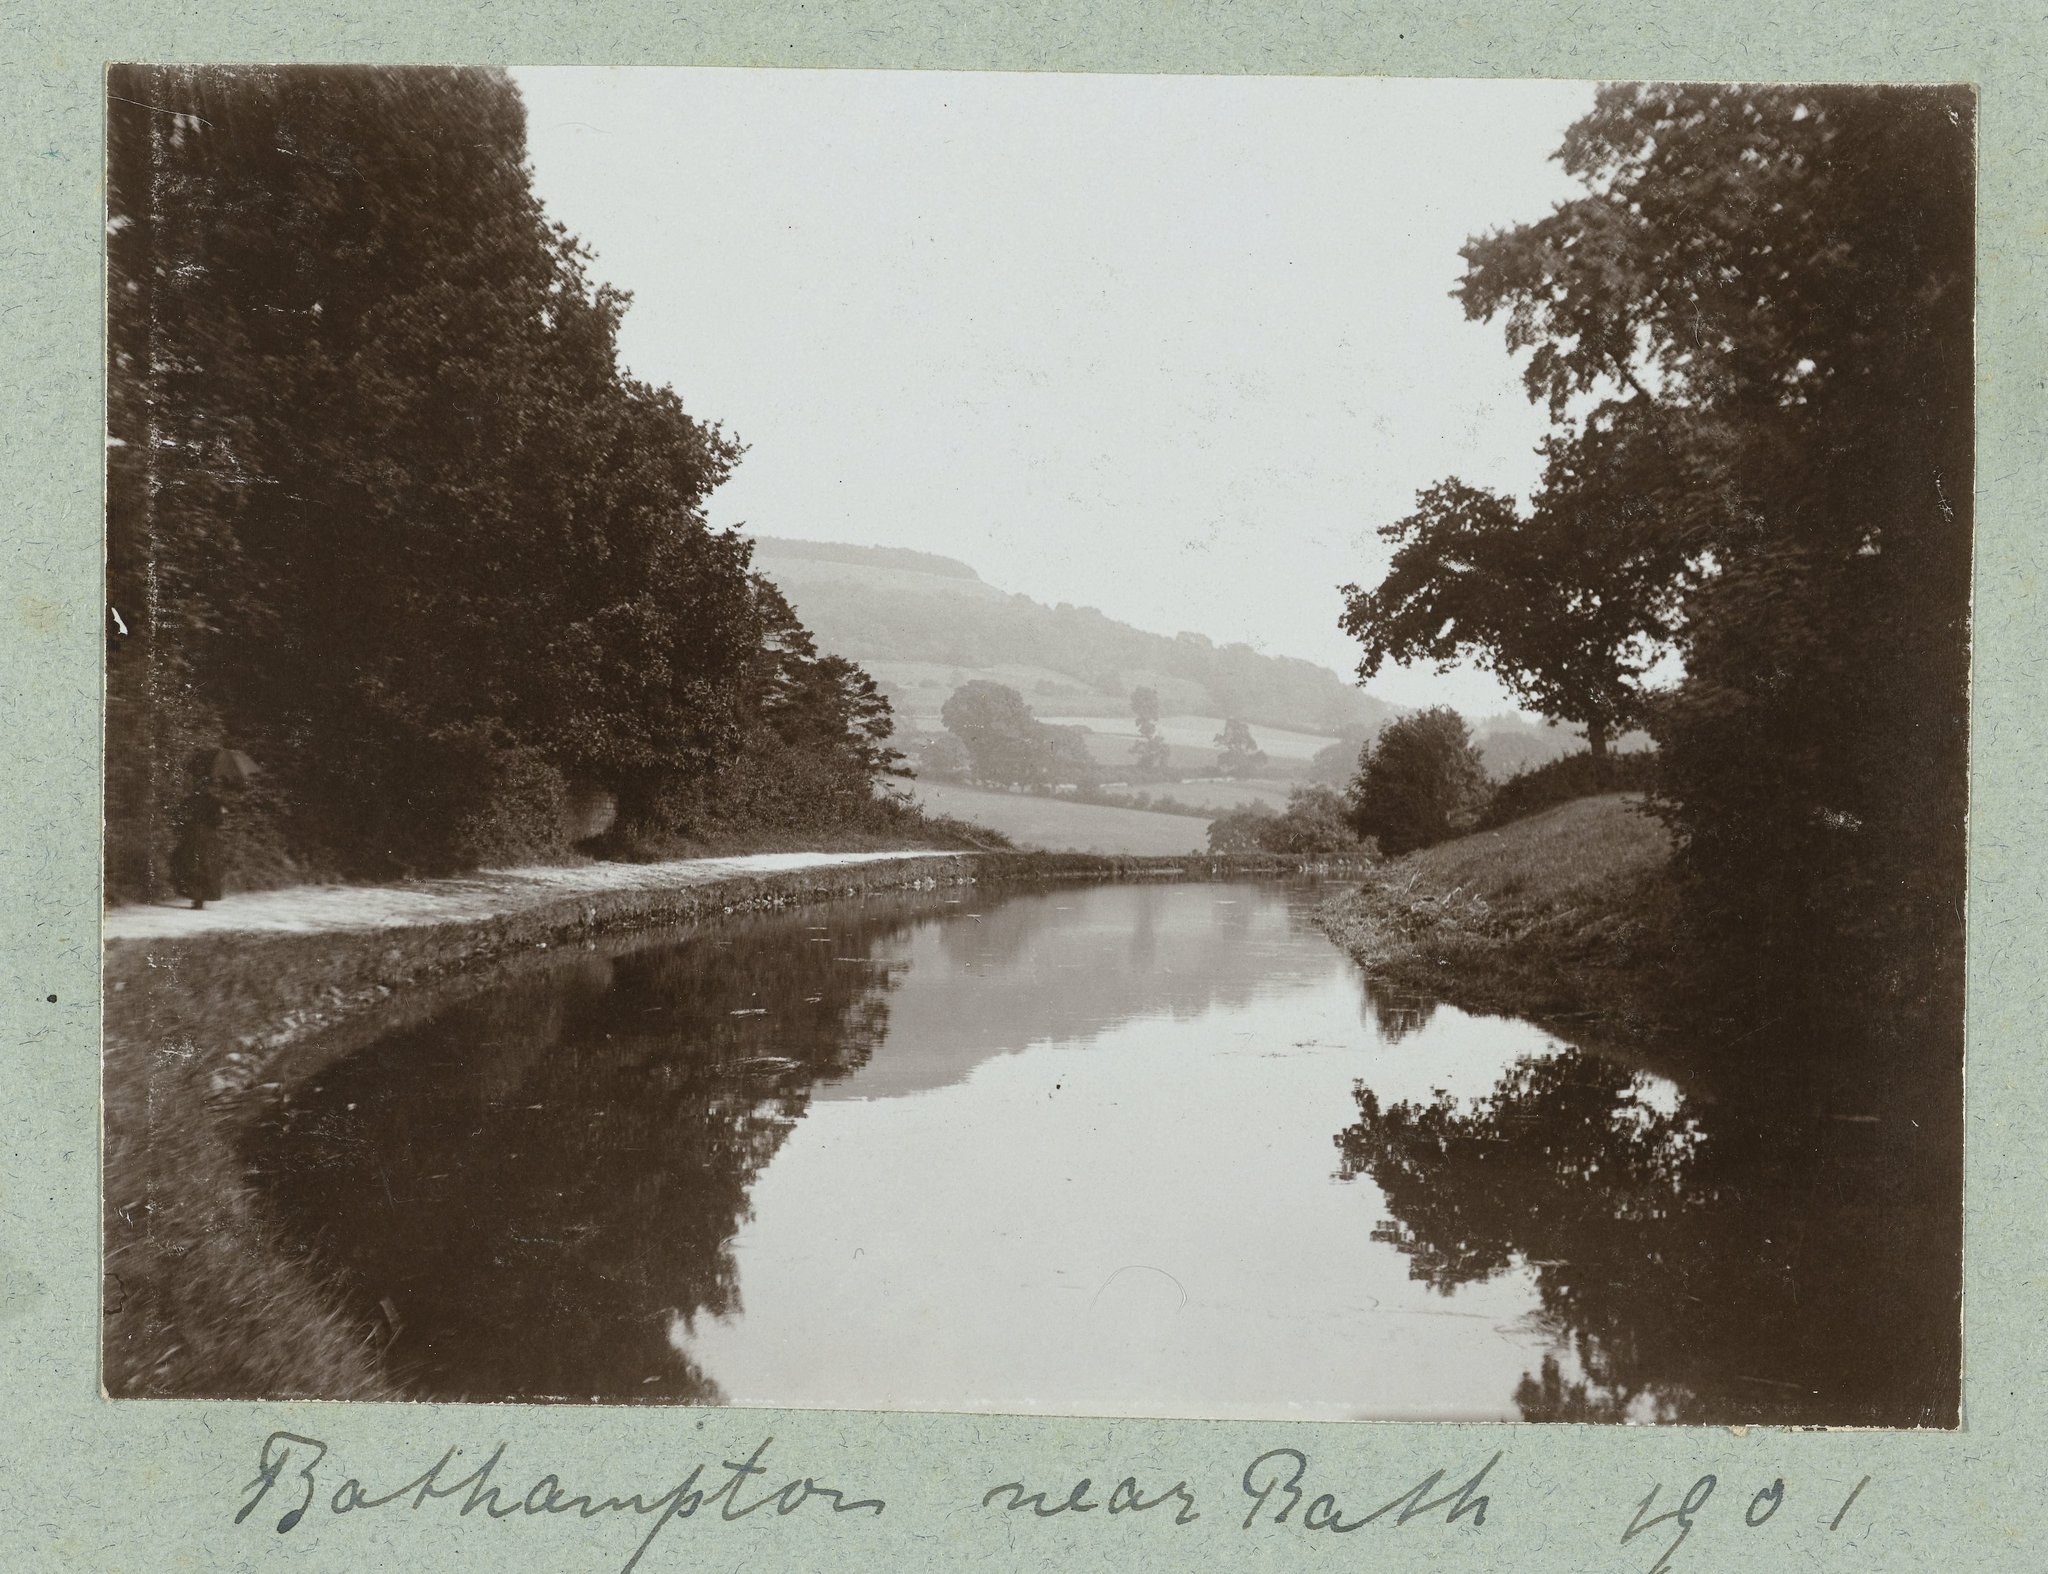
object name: photograph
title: Engeland, Bathampton near Bath 1901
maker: frits freerks fontein fz.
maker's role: fotograaf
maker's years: 1882-1928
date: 1901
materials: cardboard, paper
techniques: gelatin silver print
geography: netherlands